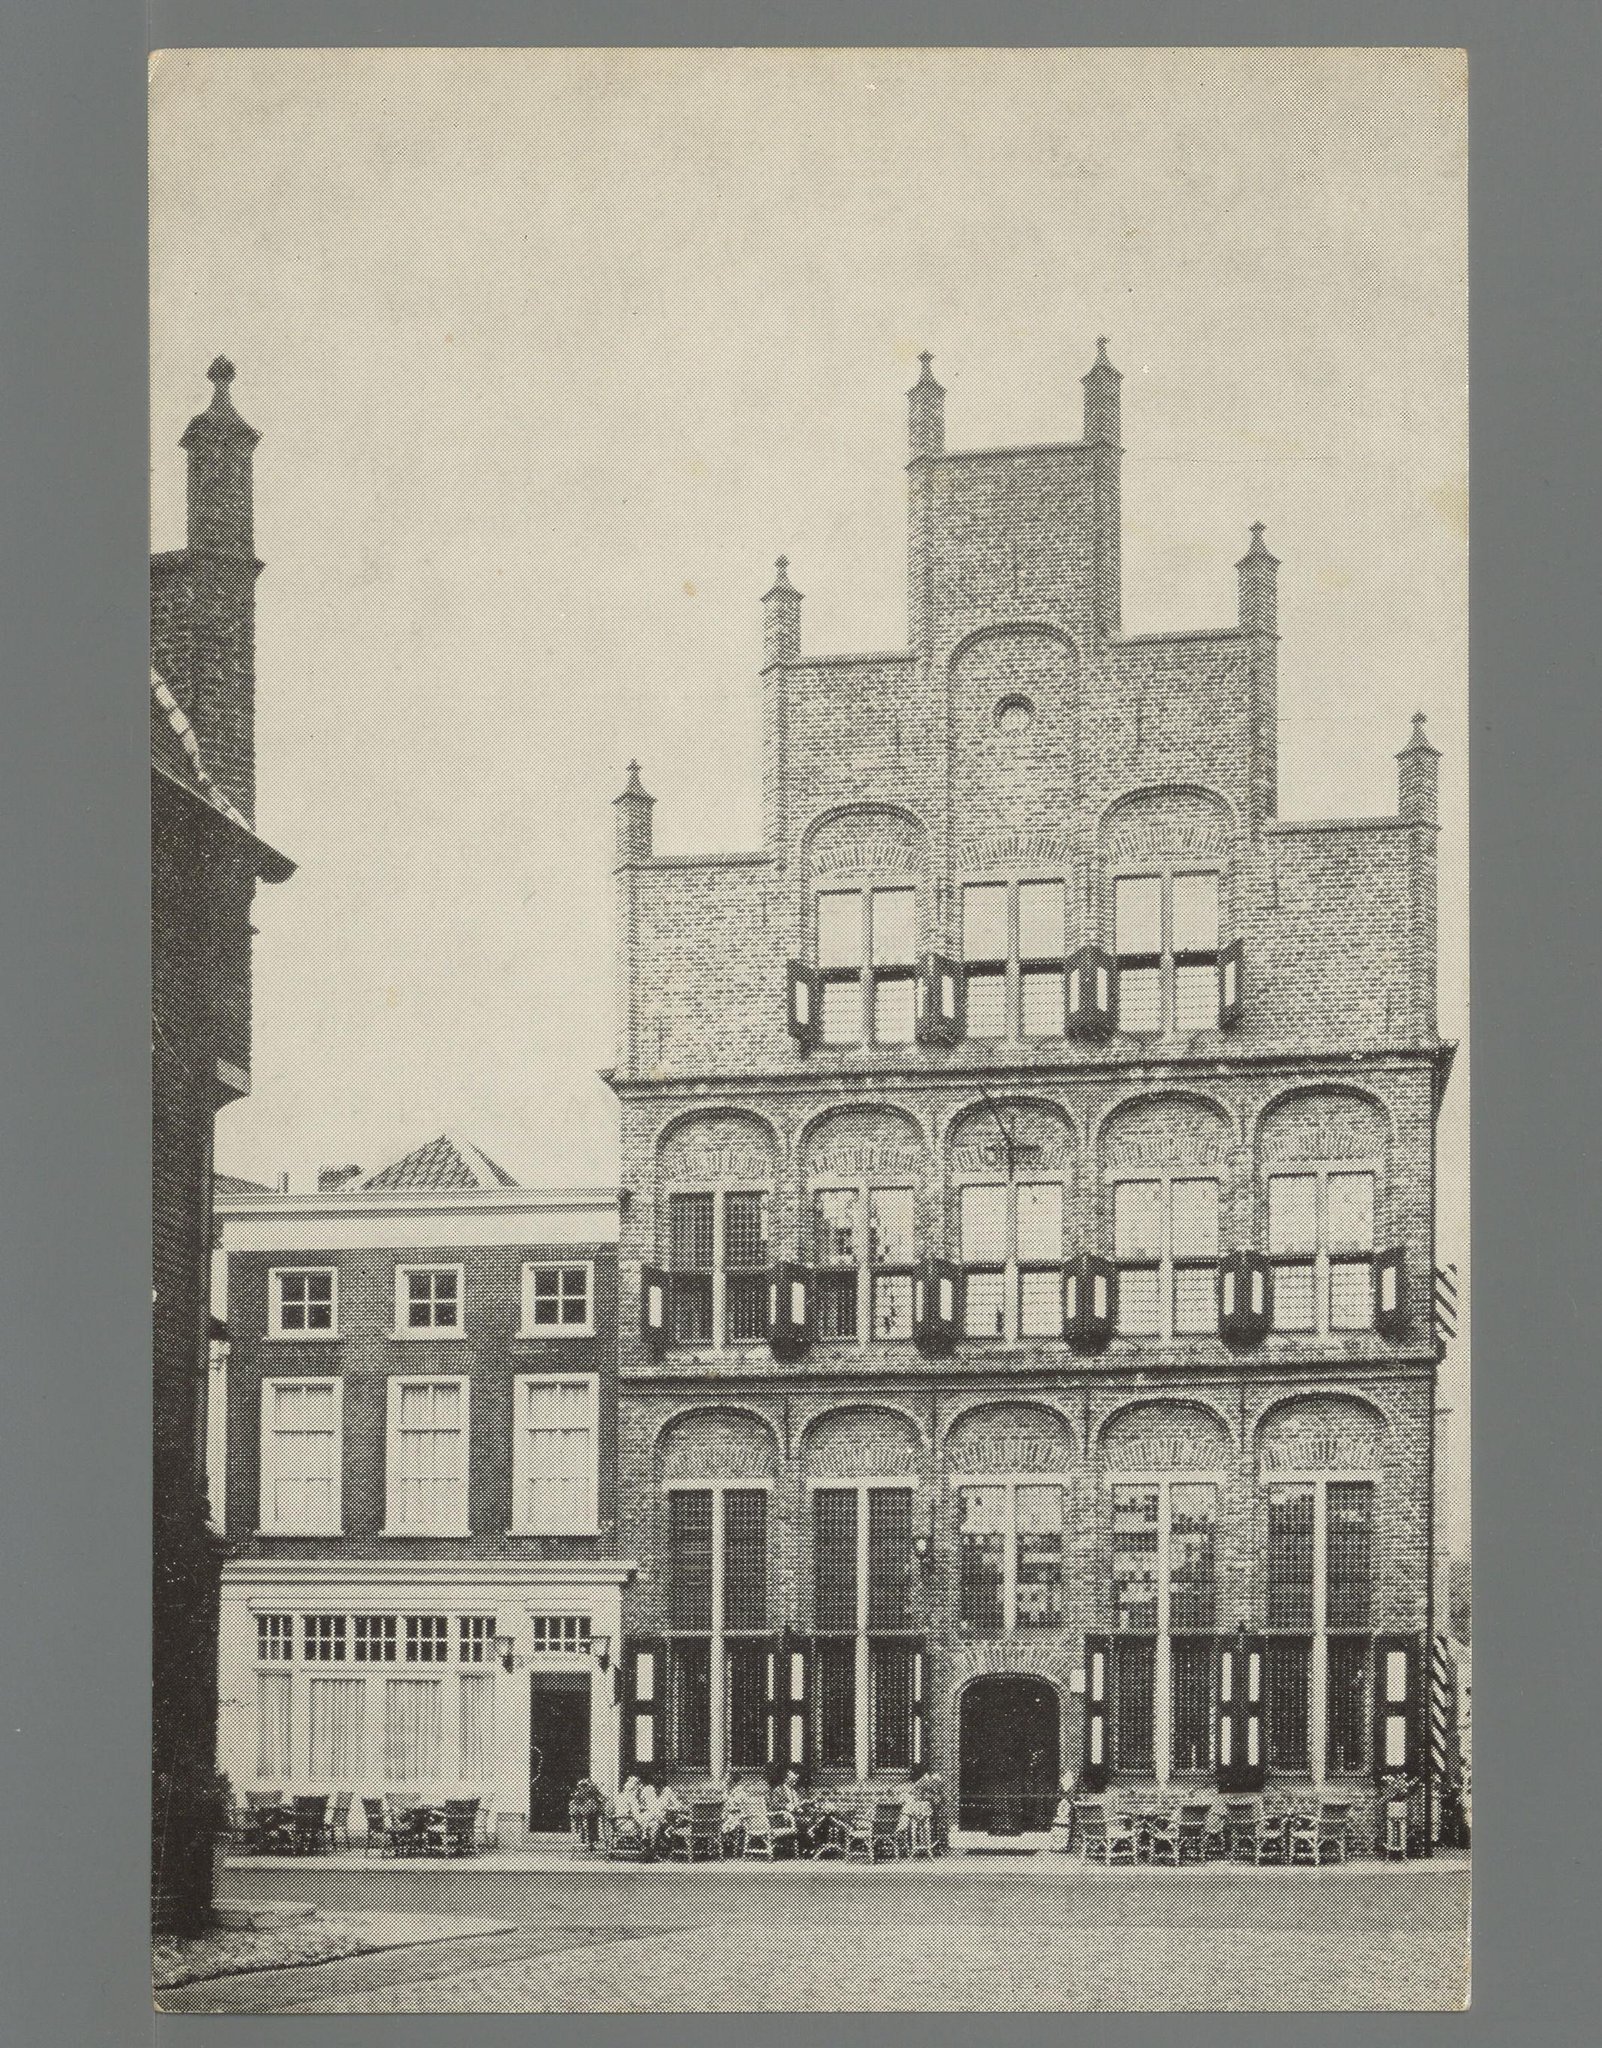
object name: photomechanical print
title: Restaurant "De Waag" Doesburg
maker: Anonymous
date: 1939-1975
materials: cardboard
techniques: autotype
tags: façade (of house or building), restaurant